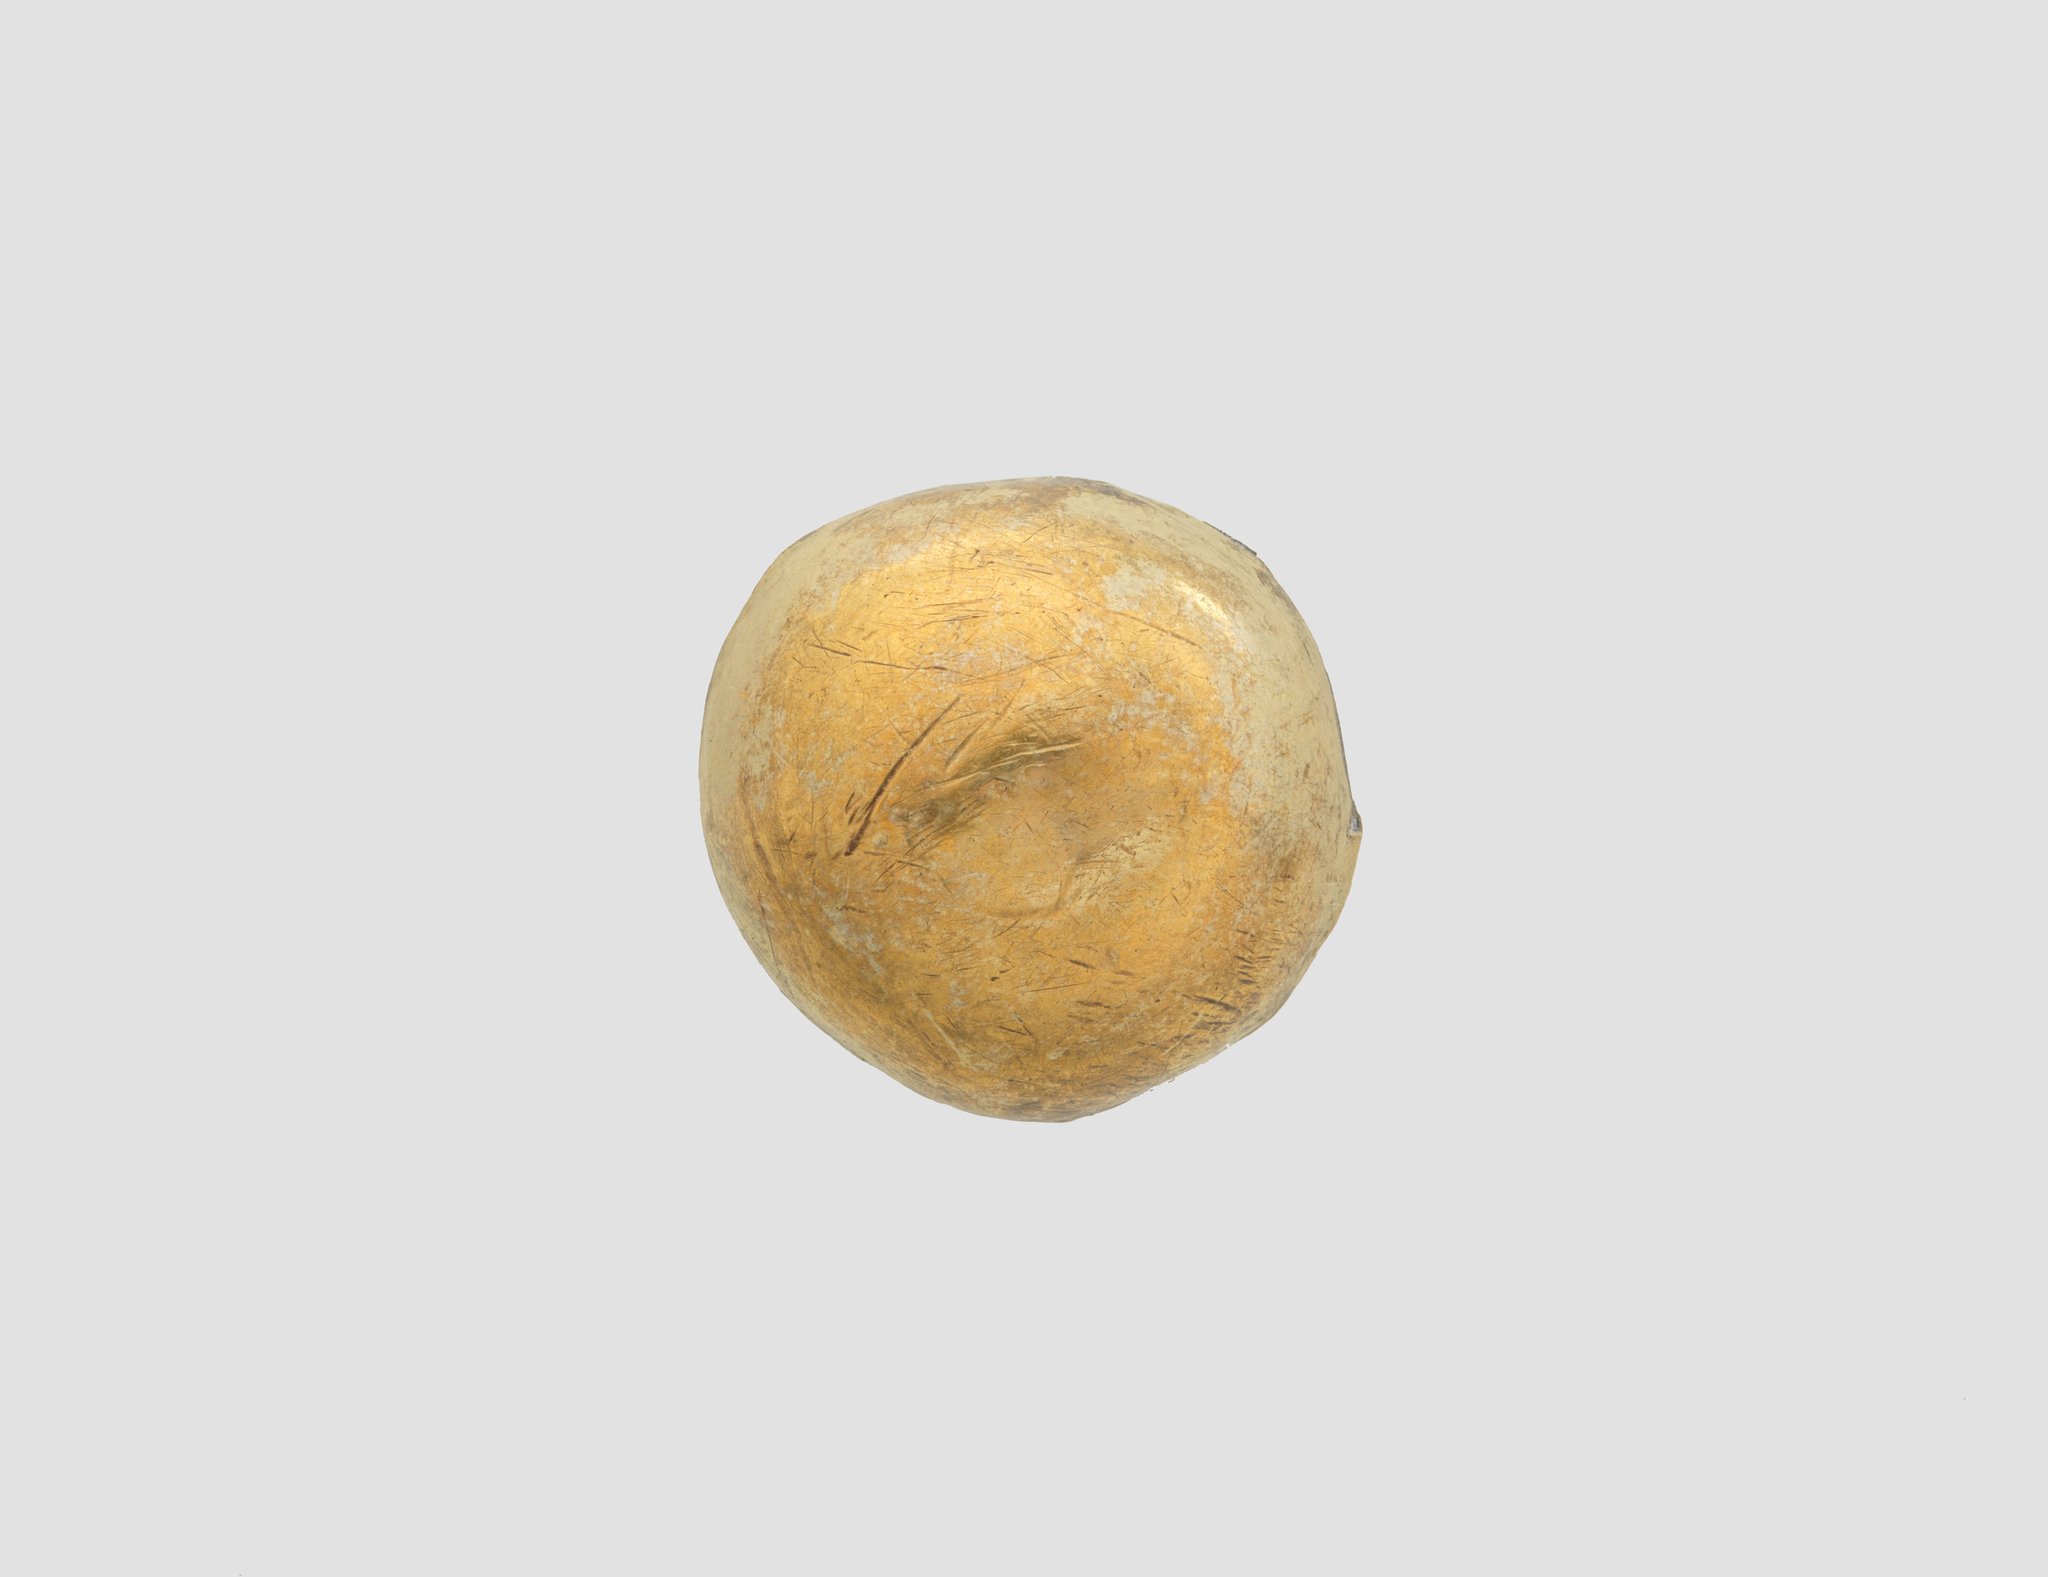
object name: stud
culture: iranian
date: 900-801 BCE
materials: bronze, copper, gold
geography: iran